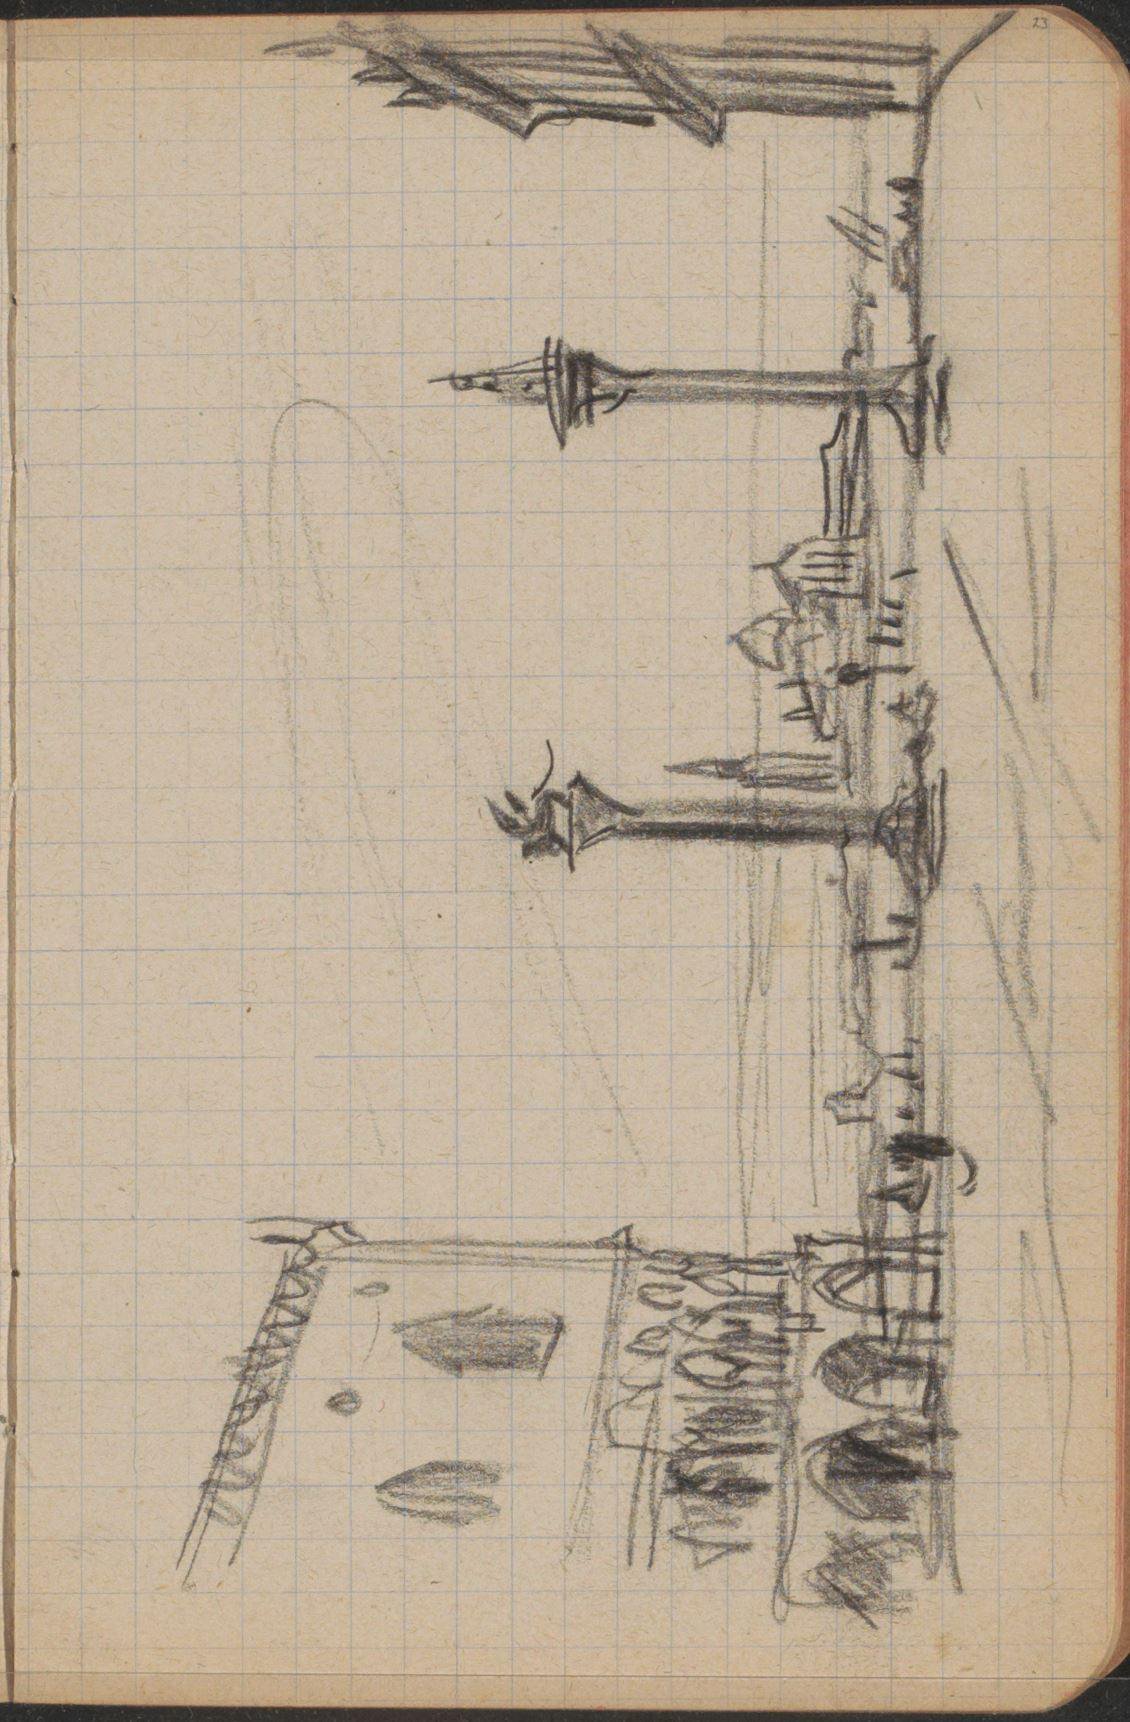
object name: sketchbook leaf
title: Zuilen op de kruising van het San Marco Plein met de Riva degli Schiavone in Venetië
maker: marius bauer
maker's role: draughtsman, print maker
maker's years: 1867-1932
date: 1895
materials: chalk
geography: venice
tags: square, place, circus, etc., column, pillar ~ architecture, palace, street (+ city(-scape) with figures, staffage)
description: Links een hoek van het Dogenpaleis. Op de achtergrond het water met zicht op de San Giorgio Maggiore. Pagina 23 uit een schetsboek met 28 bladen.